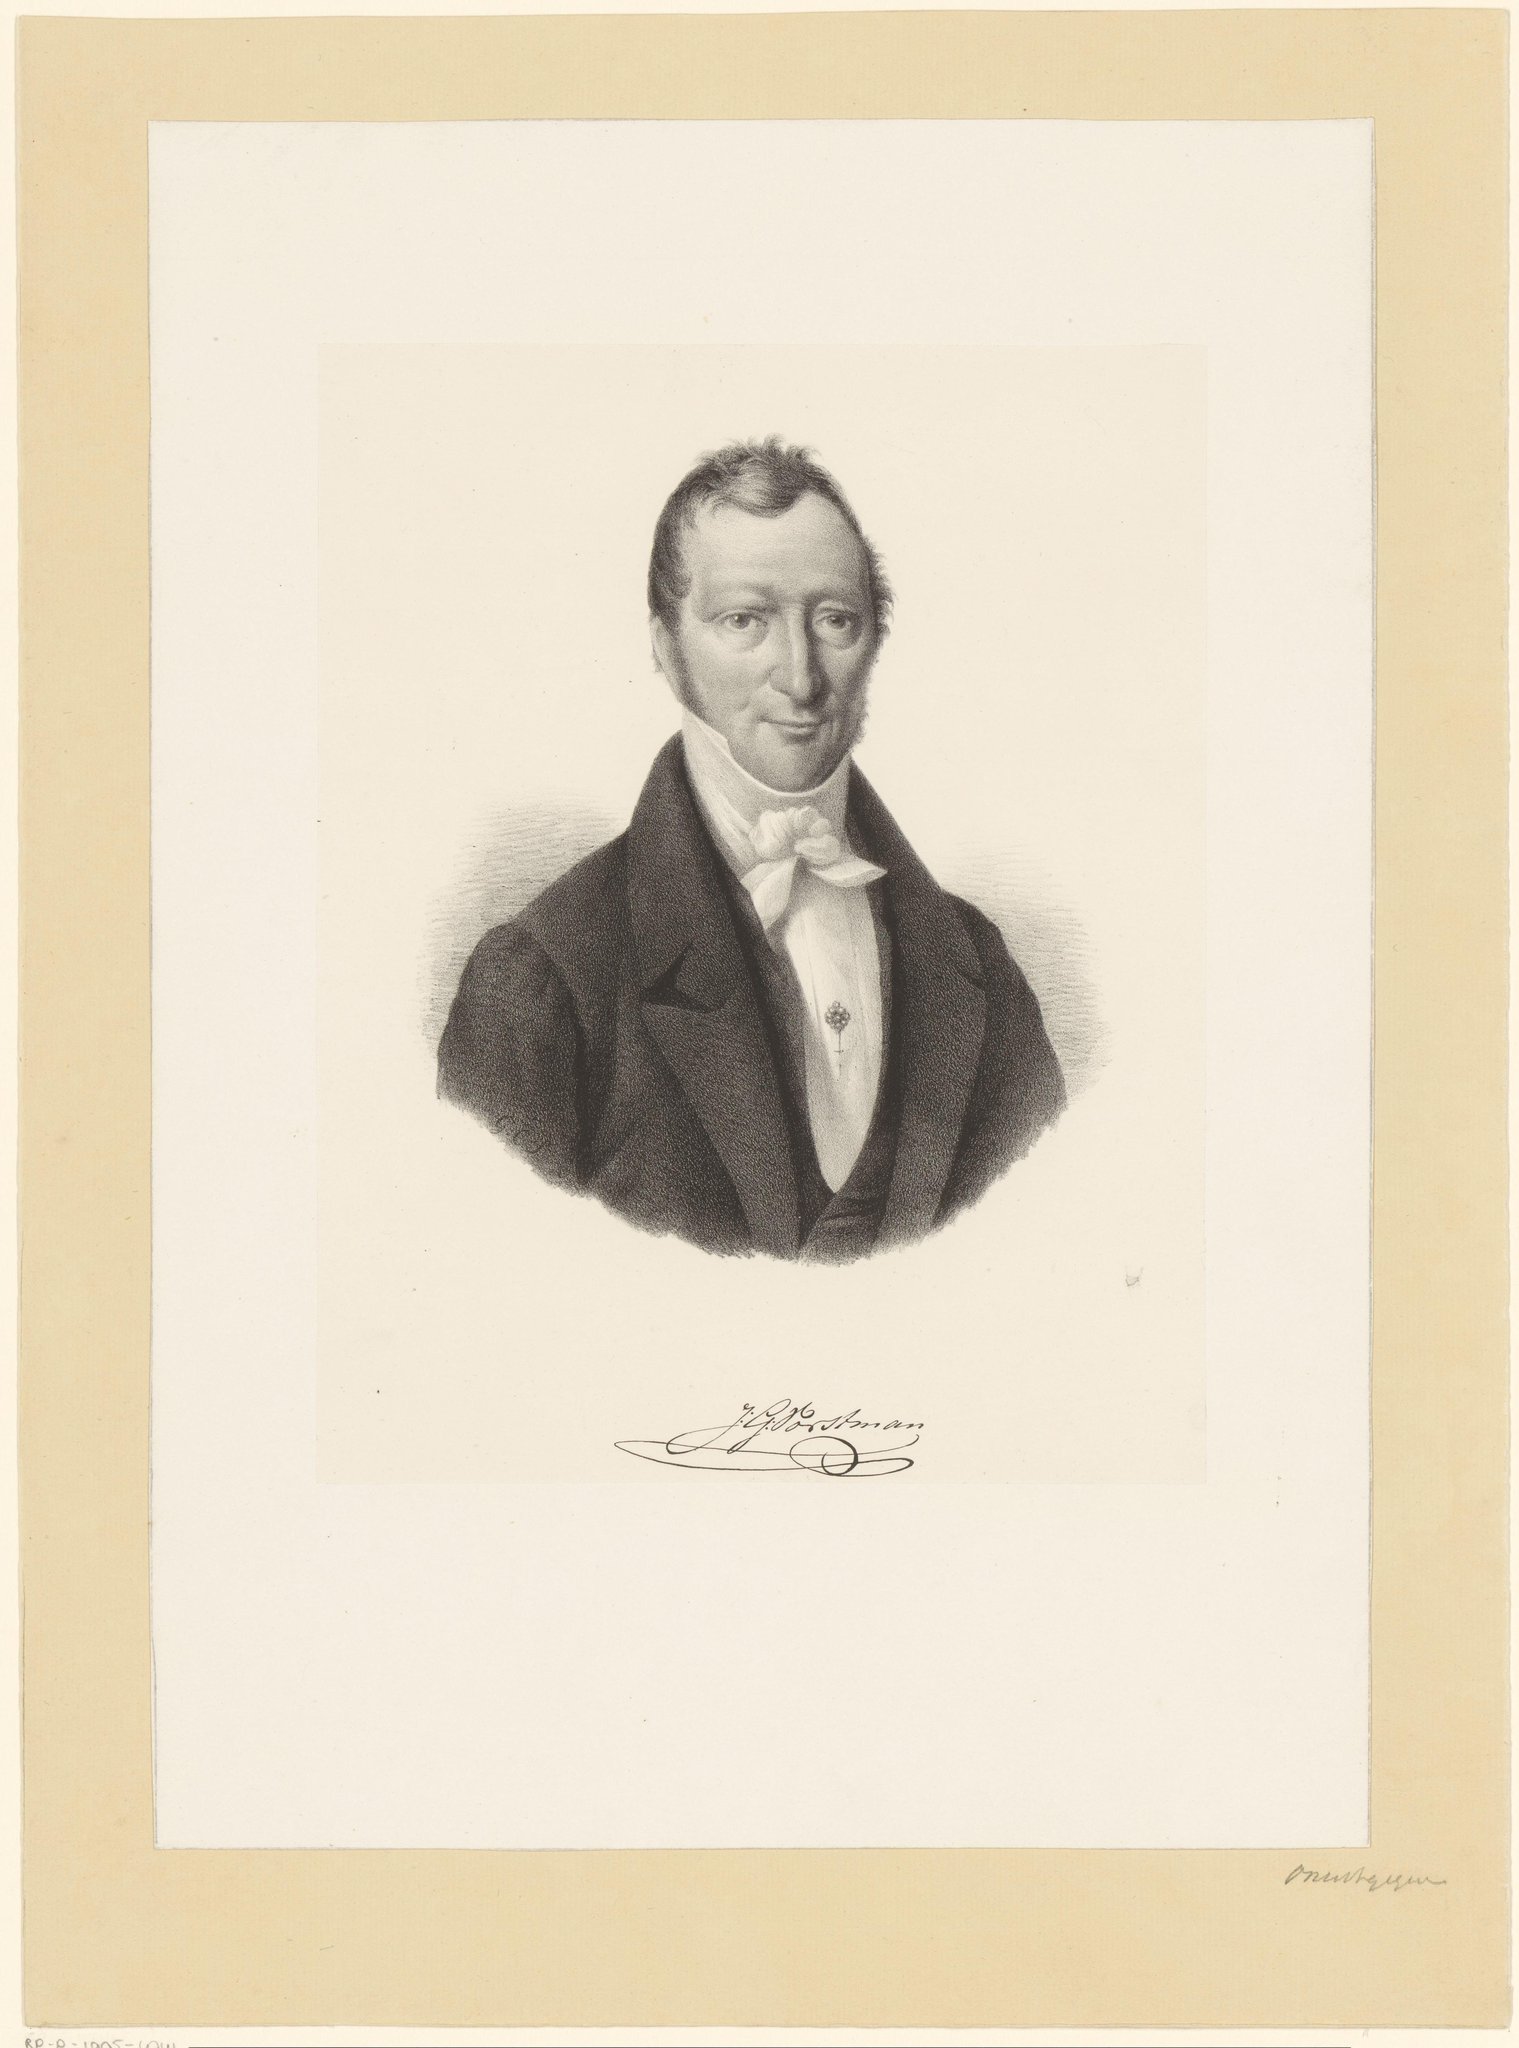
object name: print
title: Portret van Johannes Gerardus Vorstman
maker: Anonymous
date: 1820-1853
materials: paper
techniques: lithograph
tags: historical persons (+ (full) bust portrait)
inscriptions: collector's mark: Lugt 2228, monogram: ‘G.C.S.’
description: In Van Someren staat een ander monogram vermeld, namelijk: C.G.S. Volgens een opschrift op het opzetblad is deze prent verschenen in de Algemeene Konst en Letterbode in 1854.